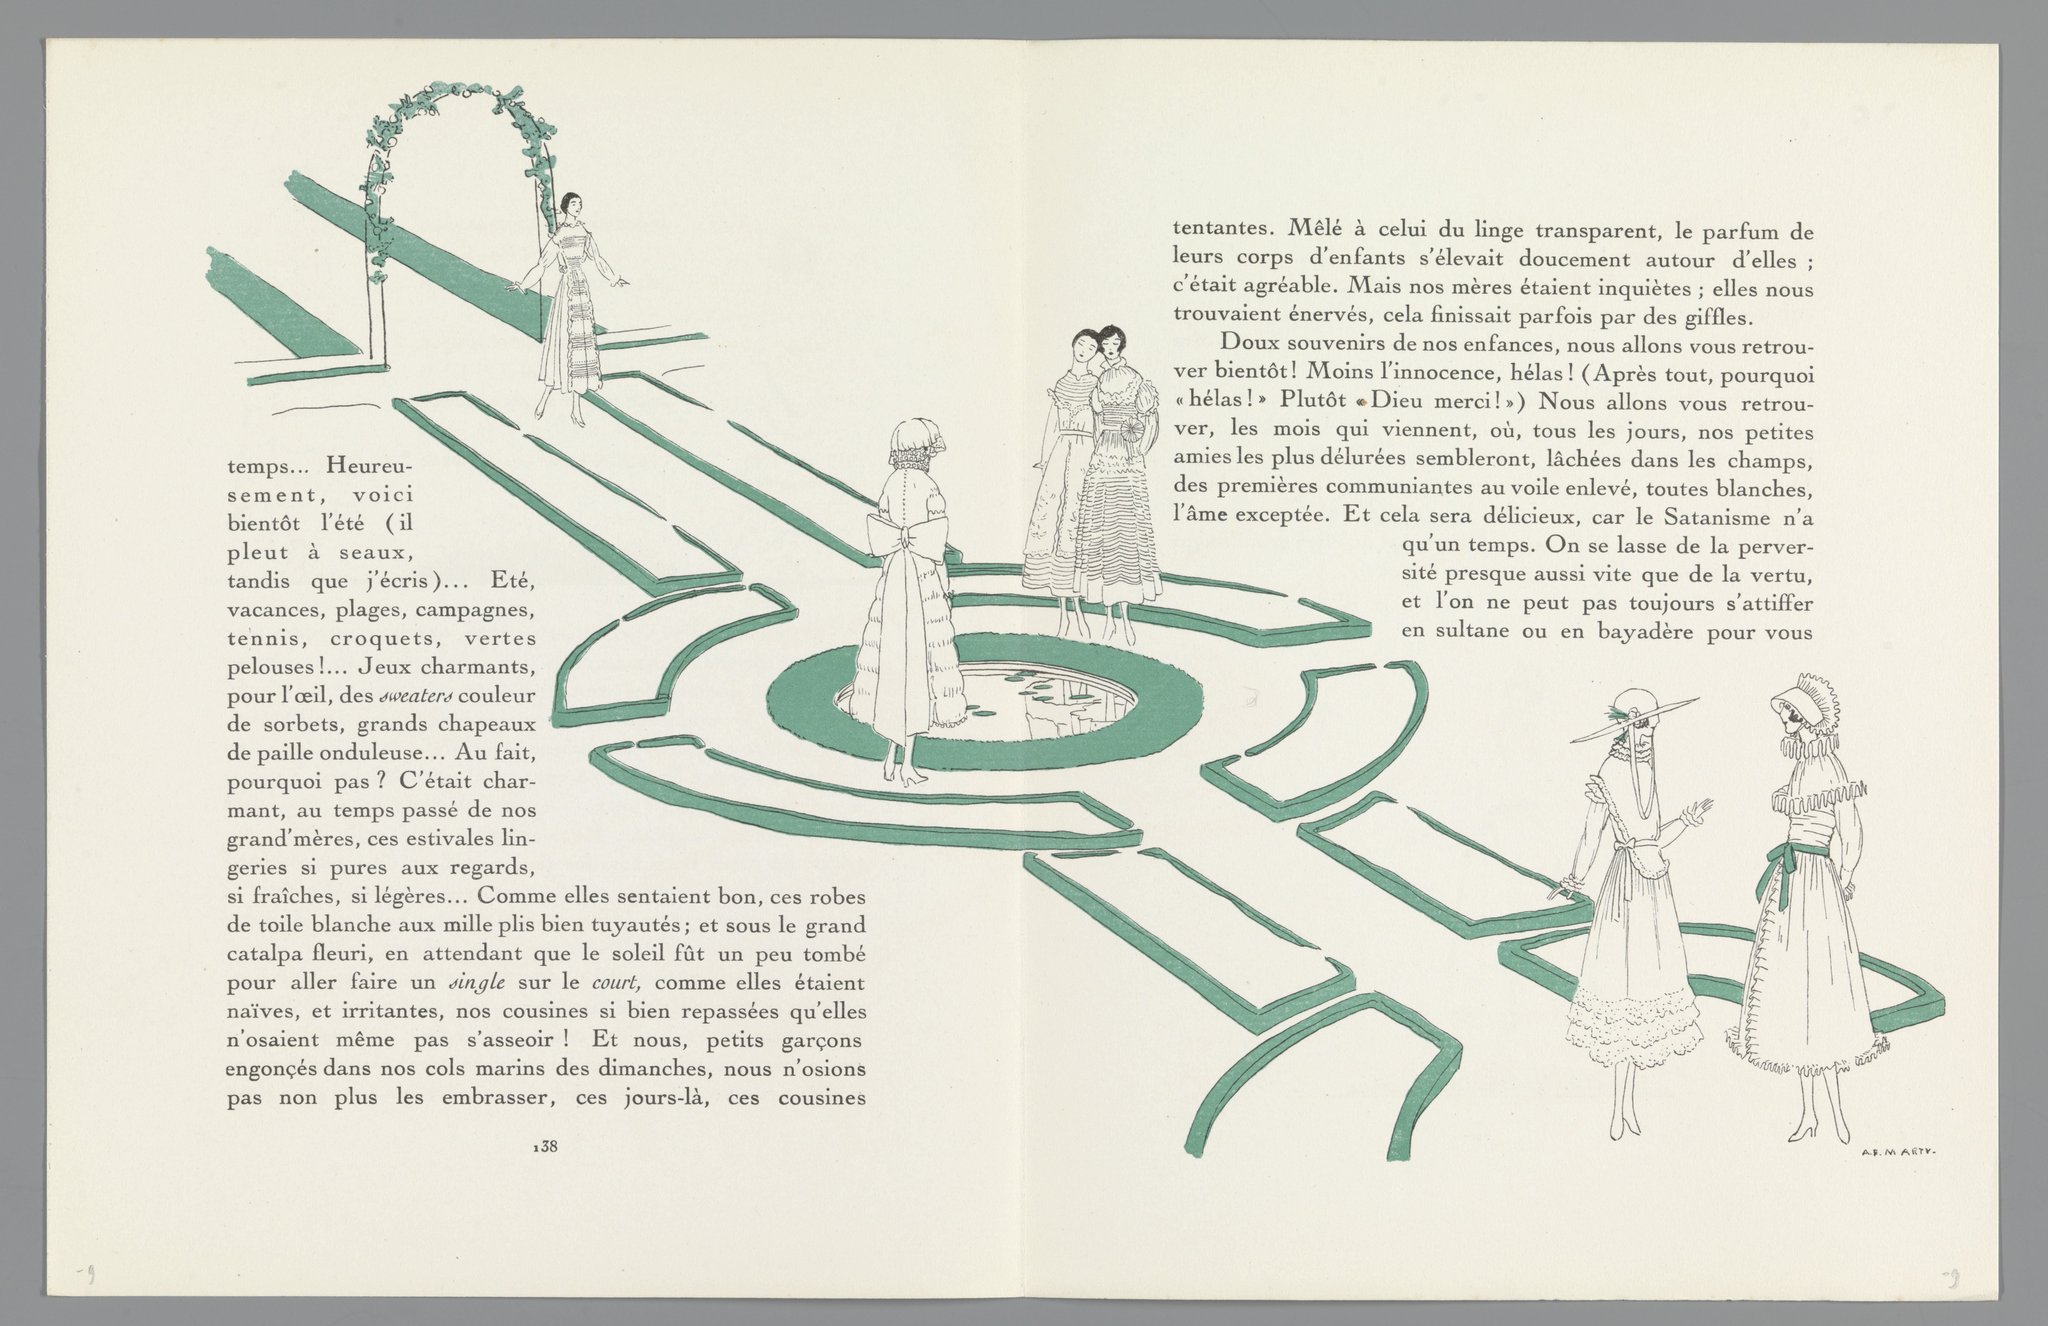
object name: fashion print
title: Gazette du Bon Ton. Art – Modes & Frivolités: Layout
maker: lucien vogel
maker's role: publisher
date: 1921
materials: paper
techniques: letterpress printing, photochemical processes, pochoir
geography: buenos aires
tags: fashion plates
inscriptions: date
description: The Gazette du Bon Ton was about more than just fashion. It was also a treat for the eyes for typographers and graphic designers. Texts and illustrations were arranged to form a harmonious whole. Rather daringly, large illus-trations often occupied an entire double-page spread.